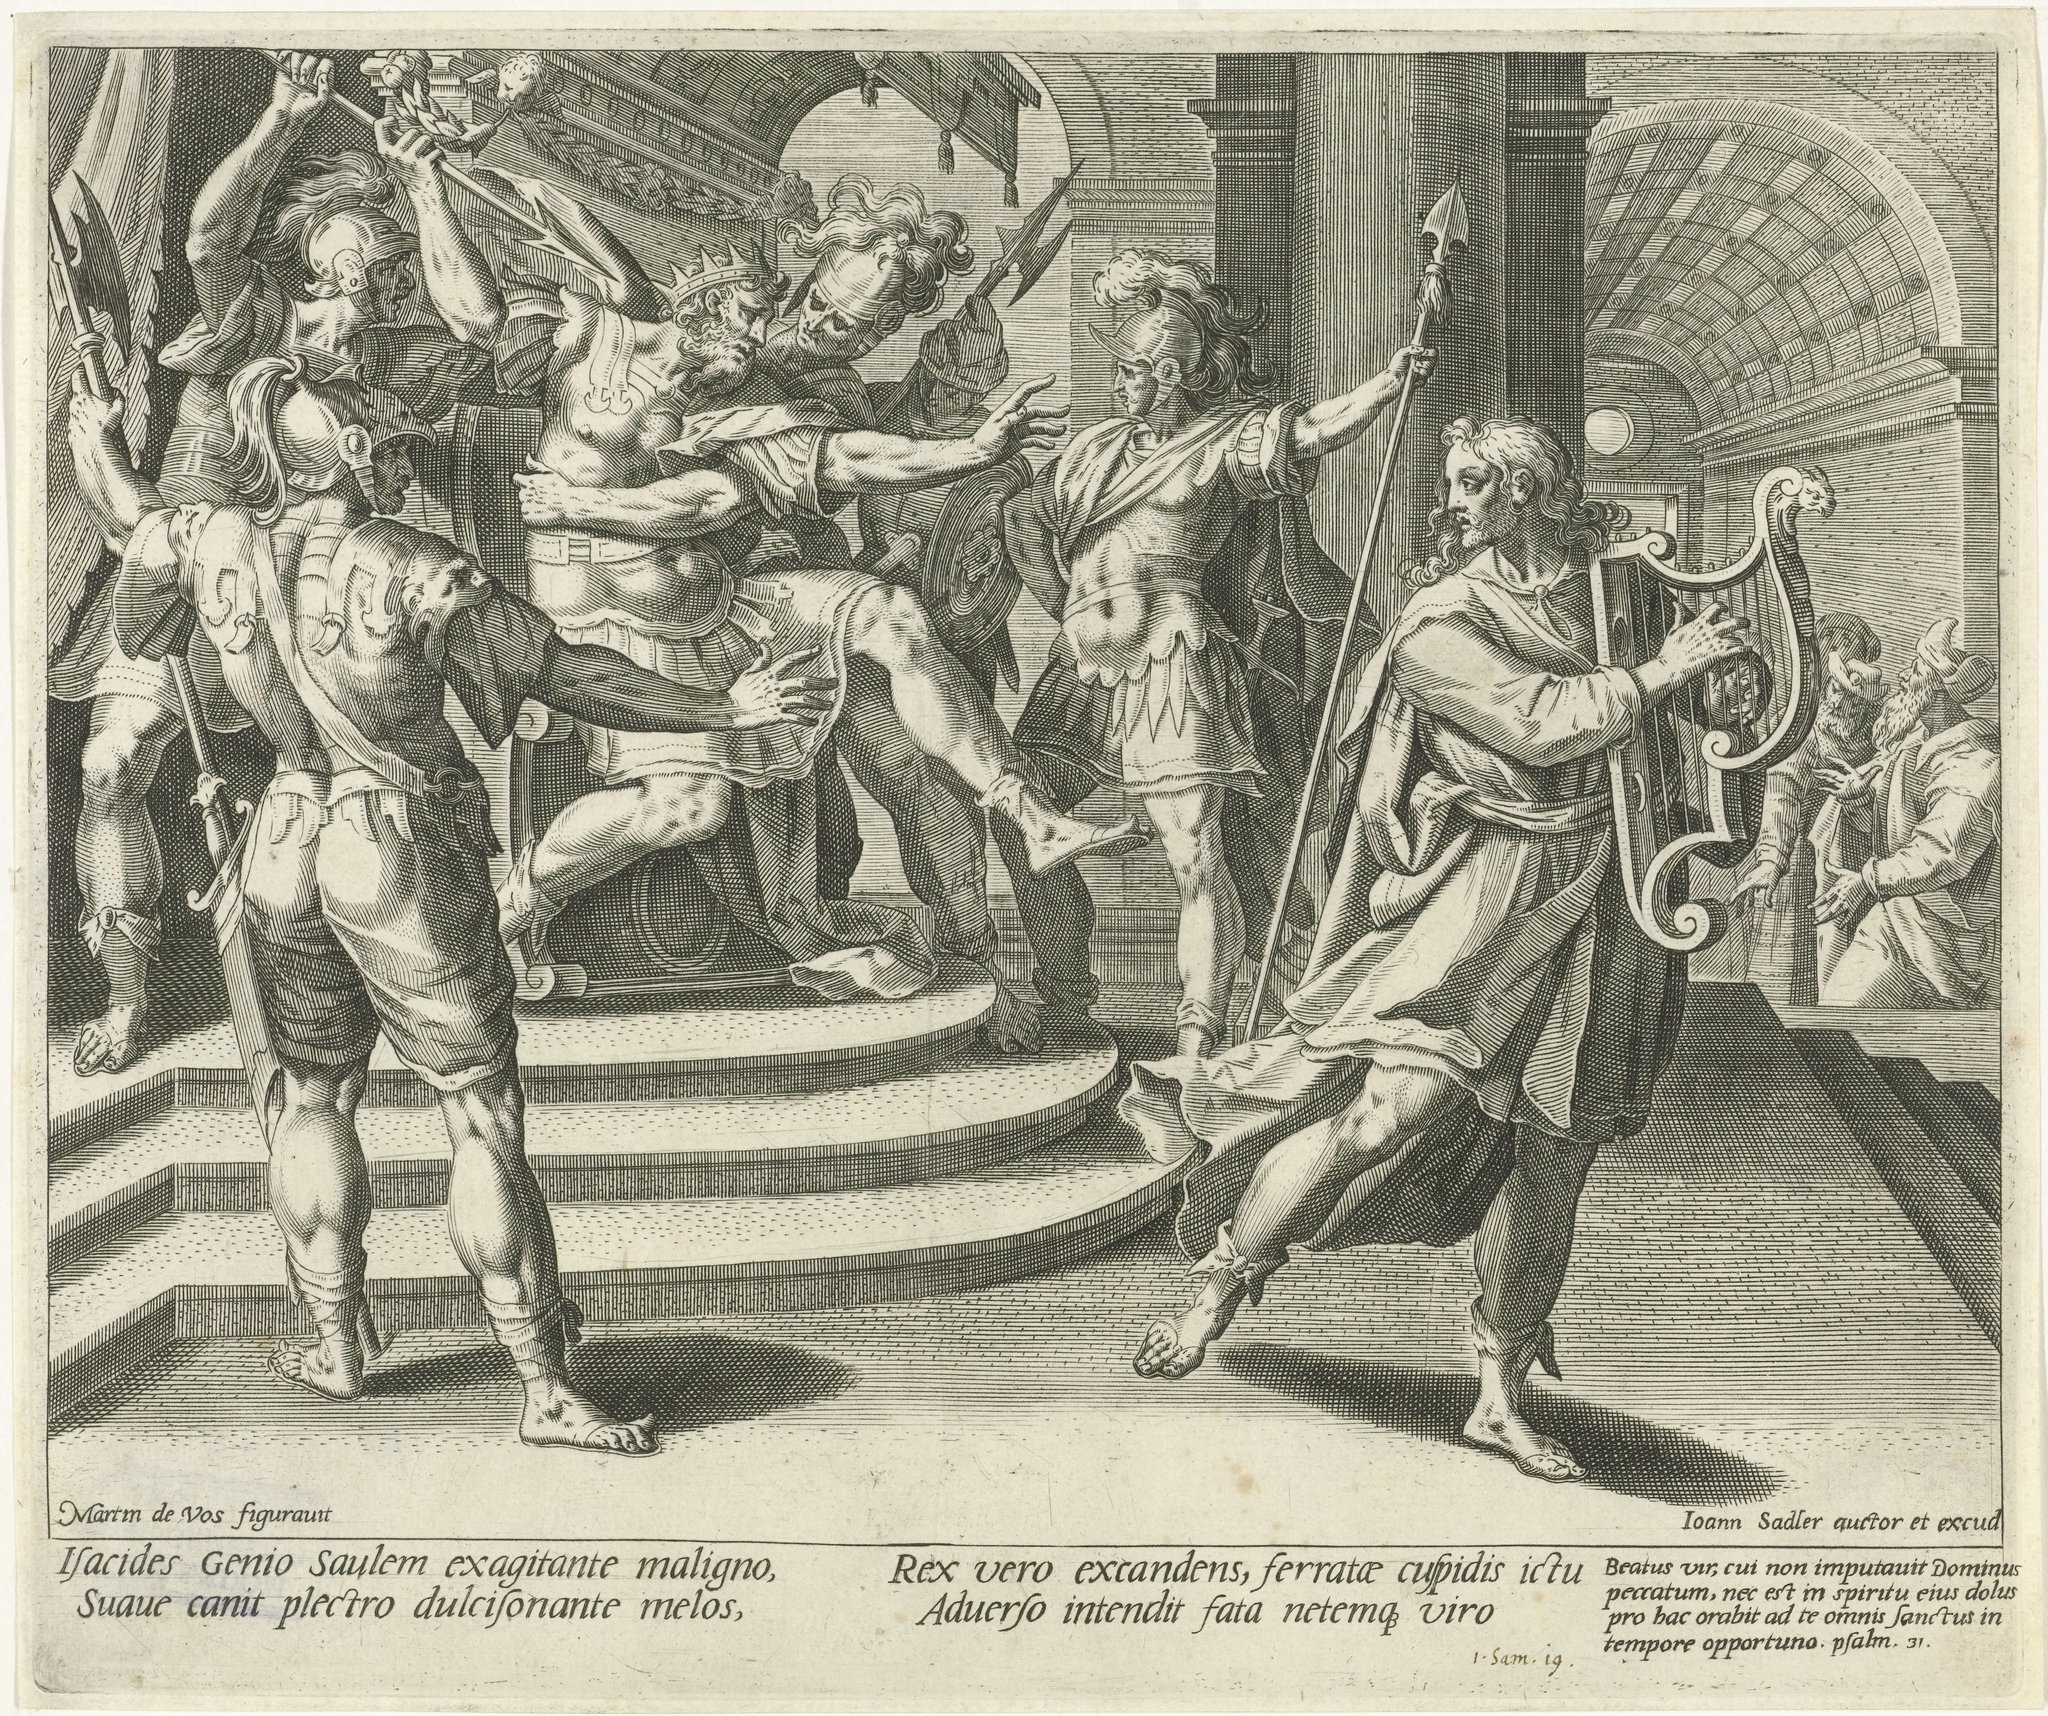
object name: print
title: Geschiedenis van David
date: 1580-1596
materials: paper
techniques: engraving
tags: saul casts his spear at david when the latter is playing his harp before the king (1 samuel 18:11)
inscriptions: inscription: ‘1 Sam. 19’, collector's mark: Lugt 11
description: De jonge David speelt op zijn harp. Hij staat voor de troon van koning Saul. Saul ontsteekt in razernij en probeert met een speer de jongen te doden. Hij wordt tegengehouden door enkele dienaren en soldaten. De prent heeft een Latijns onderschrift met uitleg en rechts in de hoek een vers uit psalm 31.